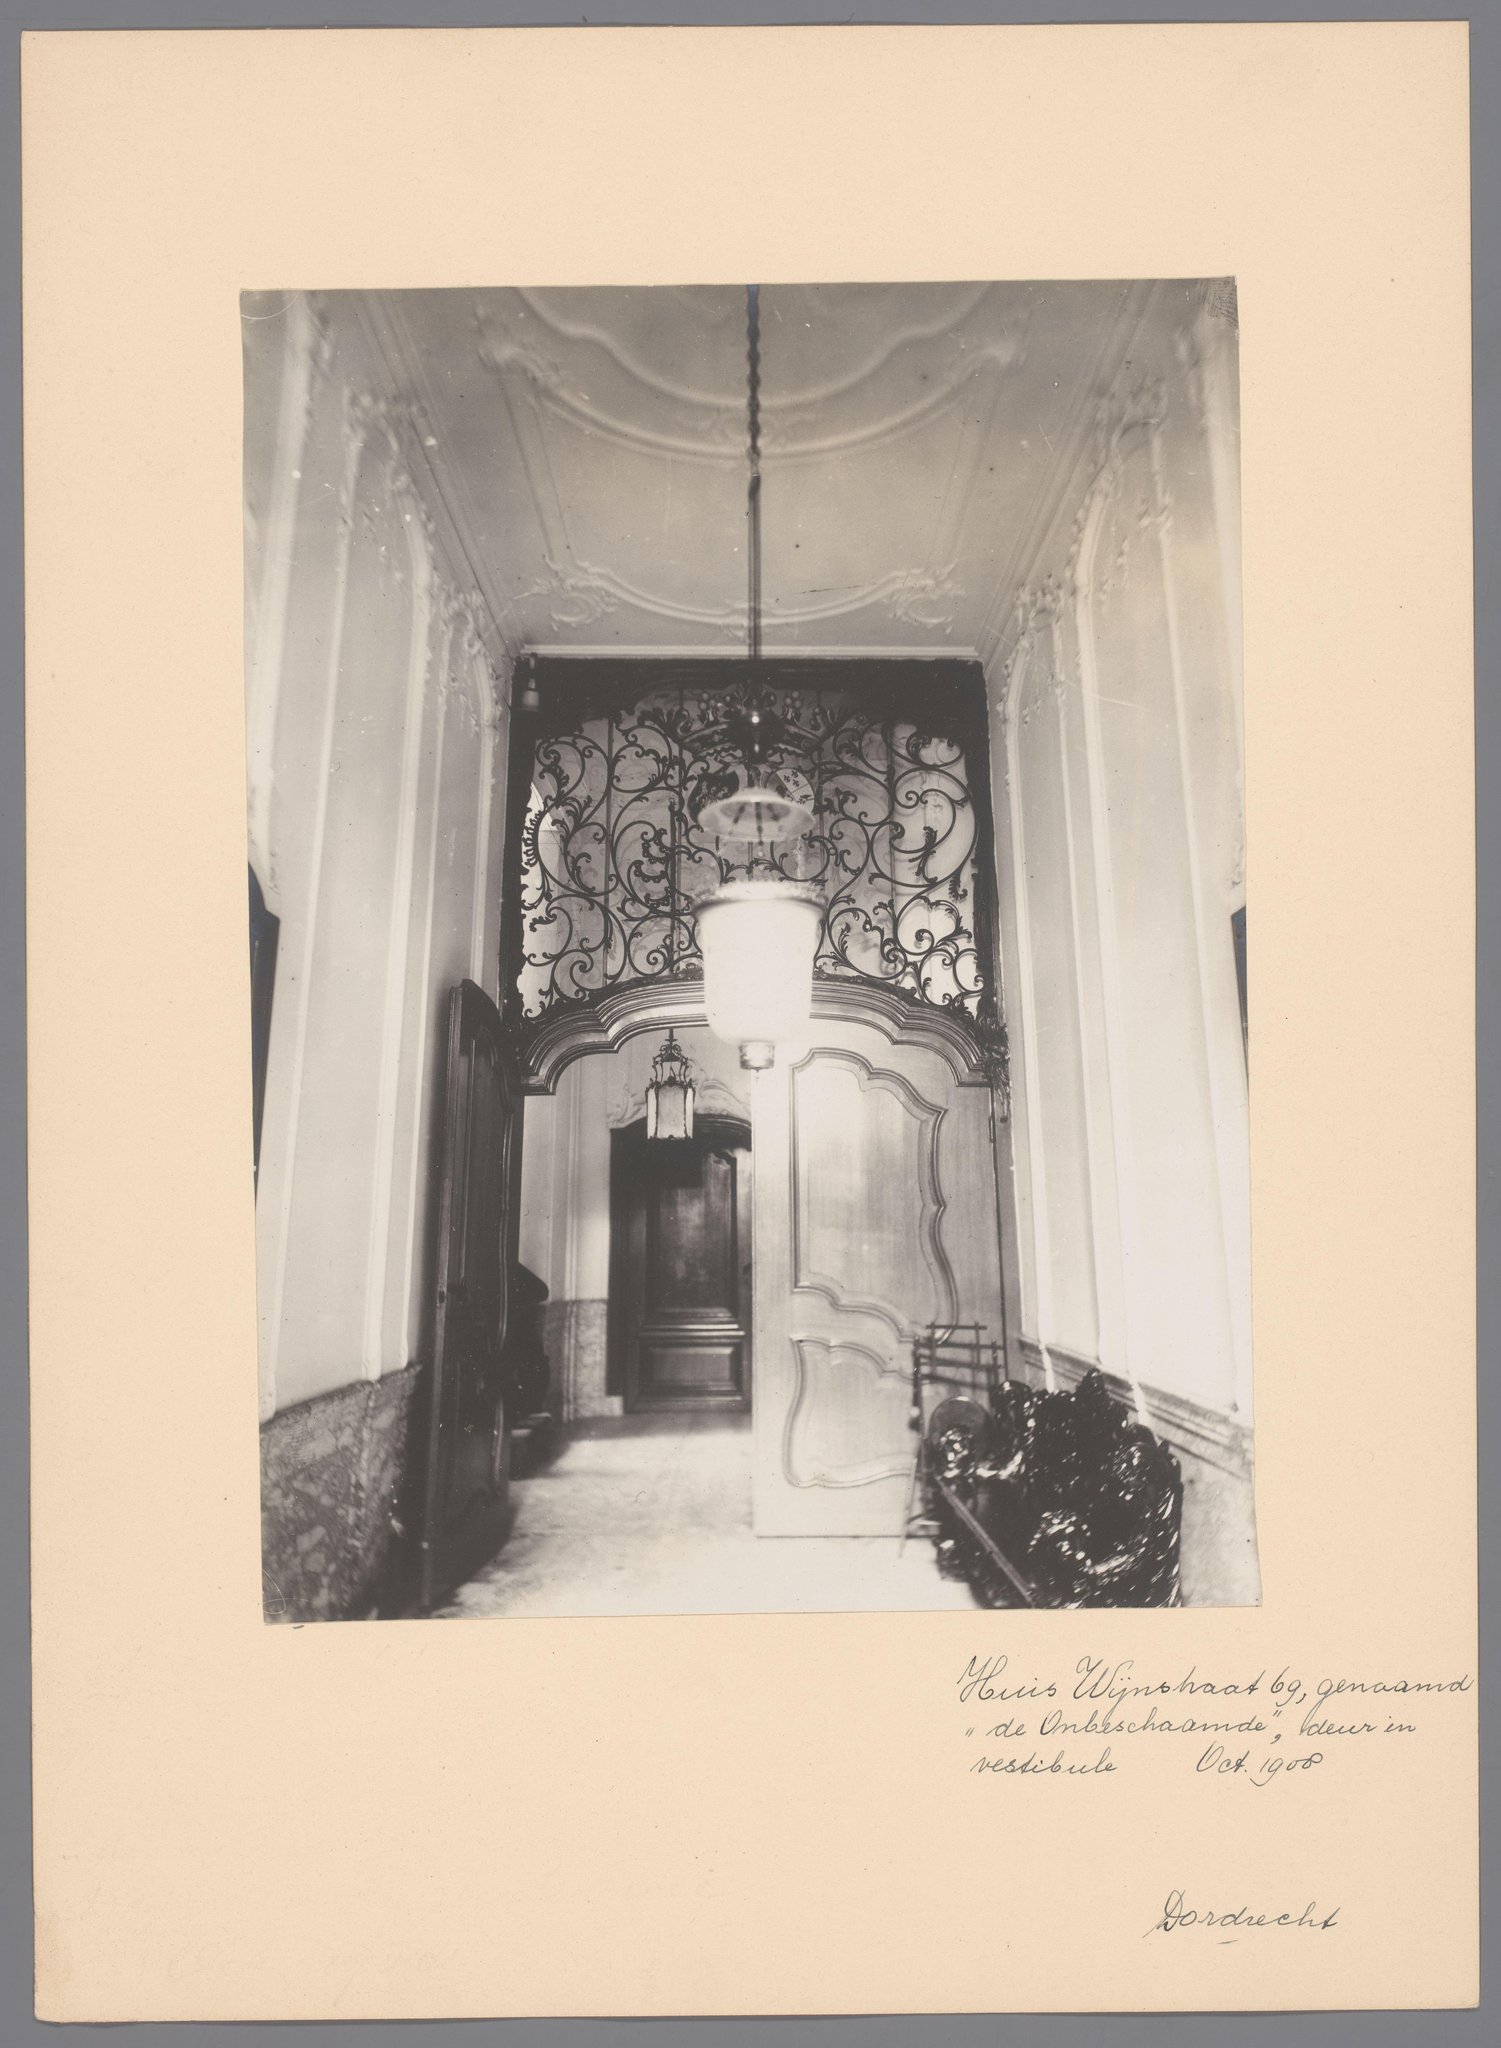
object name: photograph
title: Gezicht op een deur in de vestibule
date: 1908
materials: cardboard, photographic support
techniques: gelatin silver print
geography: wijnstraat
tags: vestibule, hall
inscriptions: annotation: ‘Huis Wijnstraat 69, genaamd "de onbeschaamde", deur in vestibule/ Oct. 1908/ Dordrecht’